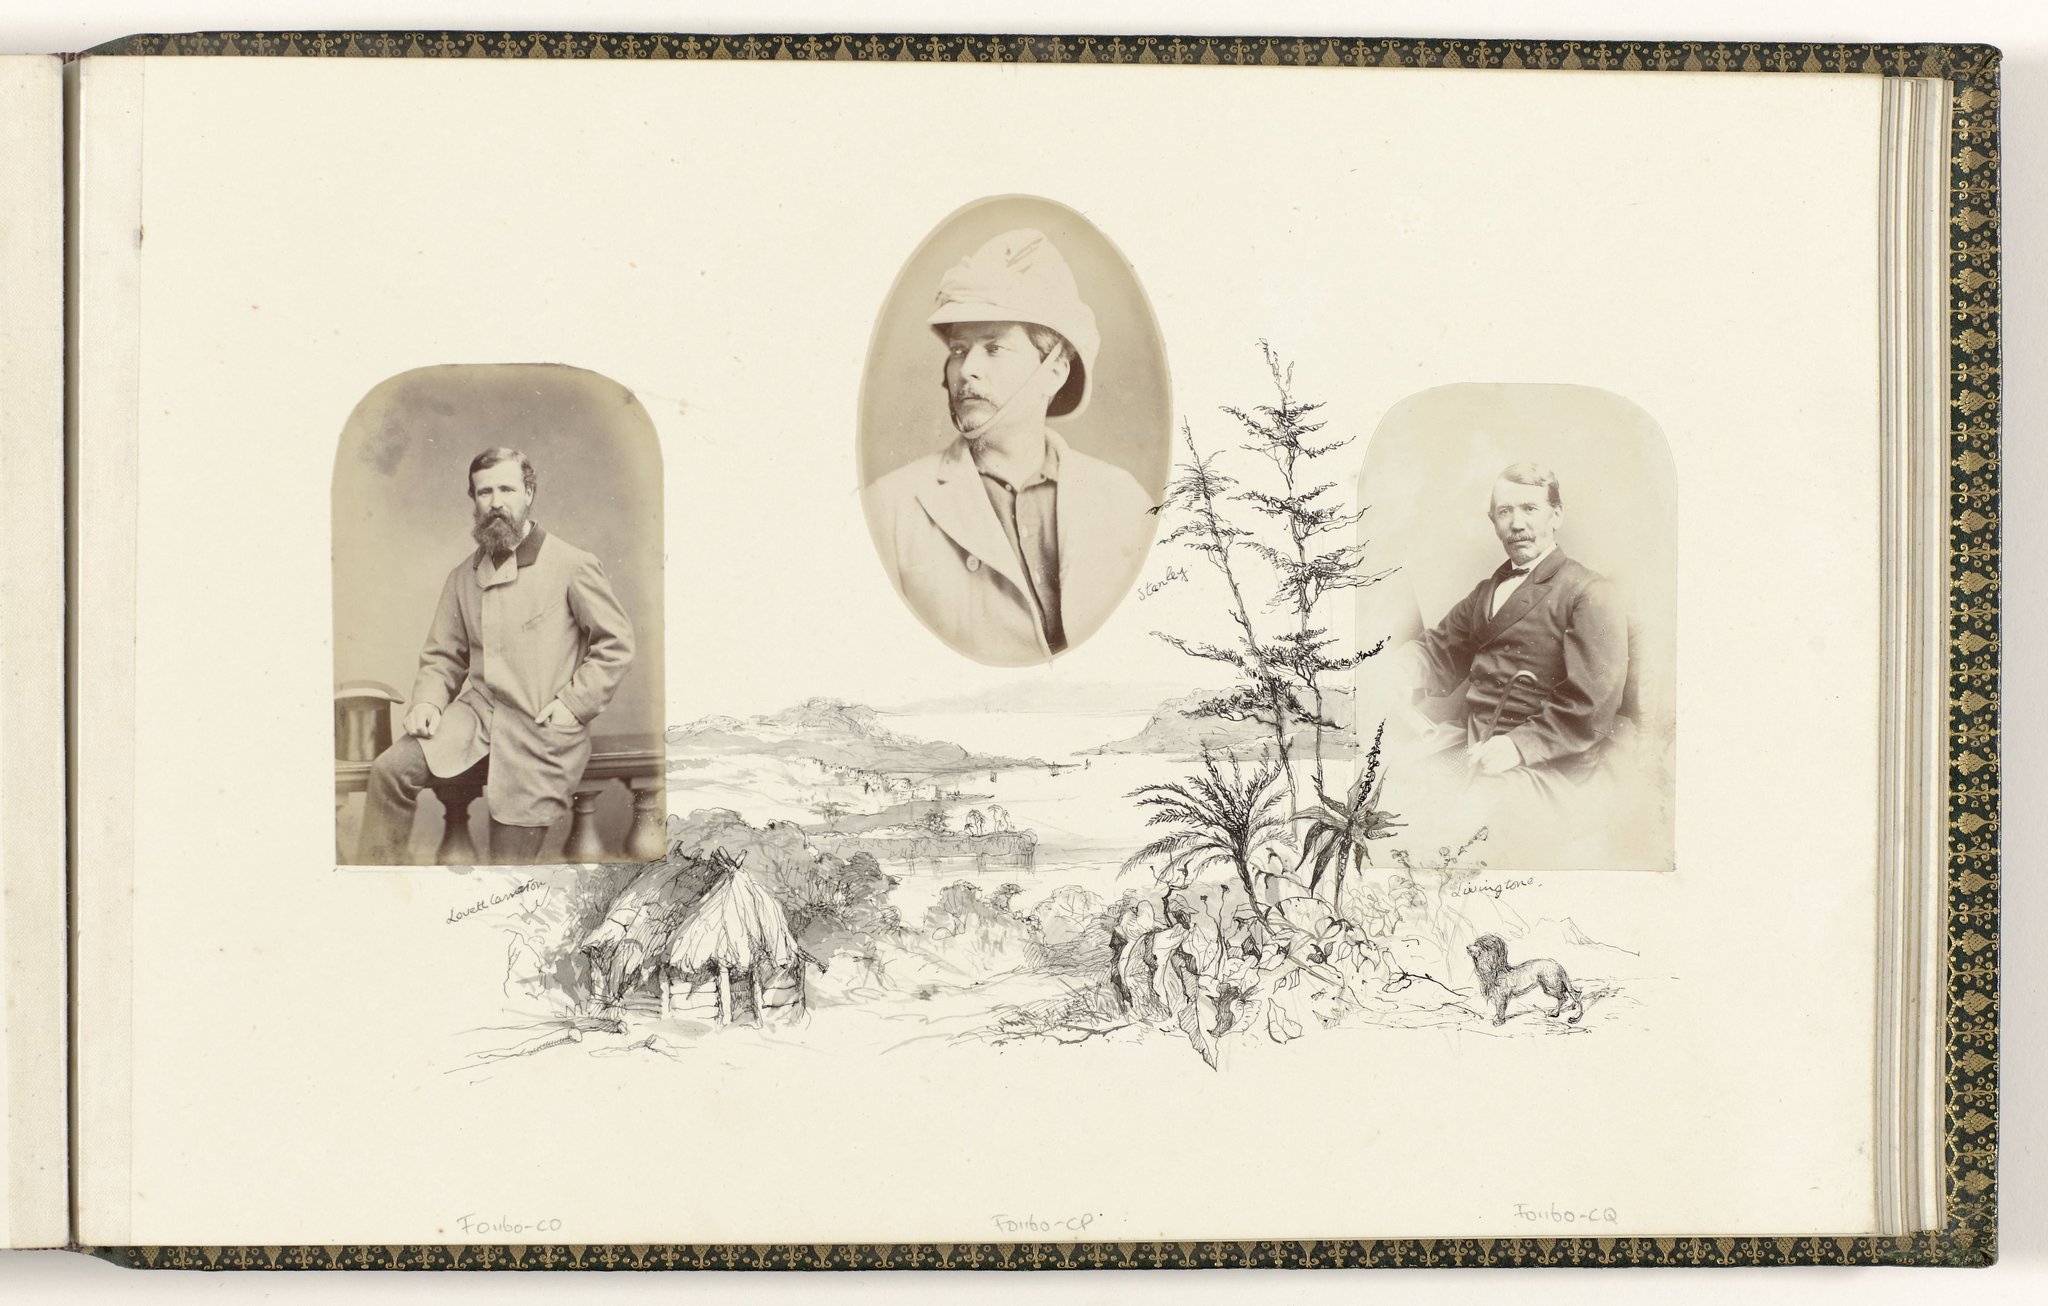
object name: album leaf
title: Portret van ontdekkingsreiziger Henry Morton Stanley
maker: Anonymous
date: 1870-1880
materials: paper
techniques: albumen print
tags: london, henry morton stanley, historical persons, explorer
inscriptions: inscription: ‘Stanley.’